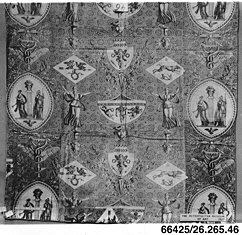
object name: furnishing textile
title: Pictorial print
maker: jean-baptiste huet i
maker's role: designer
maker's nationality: french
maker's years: 1745-1811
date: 1805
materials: cotton, linen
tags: human figures